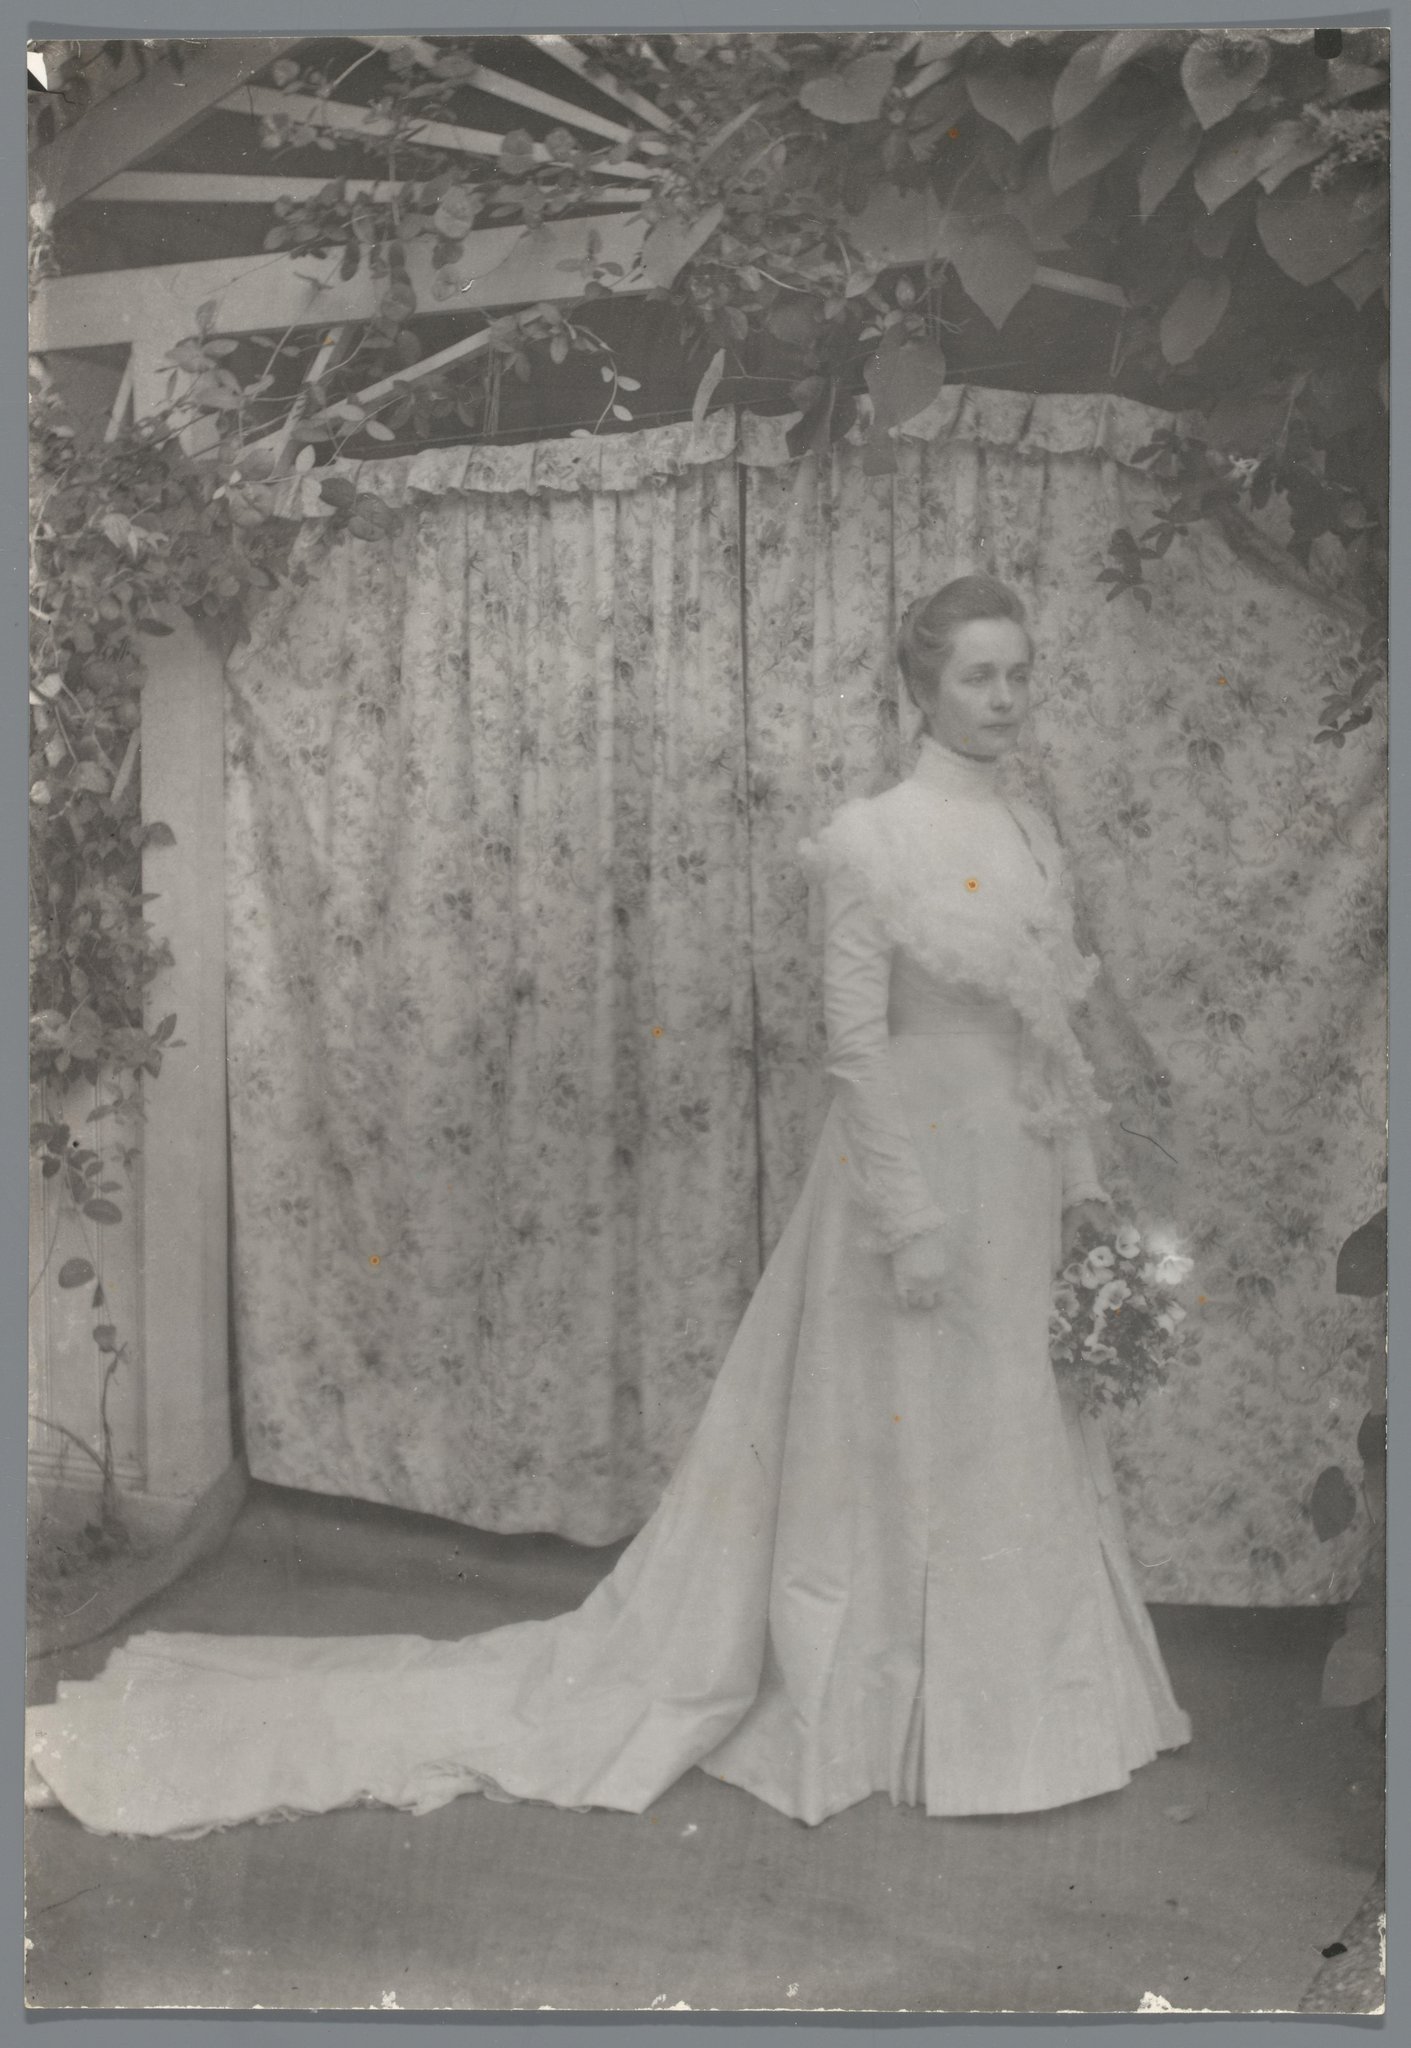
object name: photograph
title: Portret van een onbekende vrouw in haar bruidsjurk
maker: cornelia hendrika jonker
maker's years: 1874-1924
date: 1910-1960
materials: photographic support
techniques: gelatin silver print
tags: historical persons - bb - woman, bride (in wedding-dress)